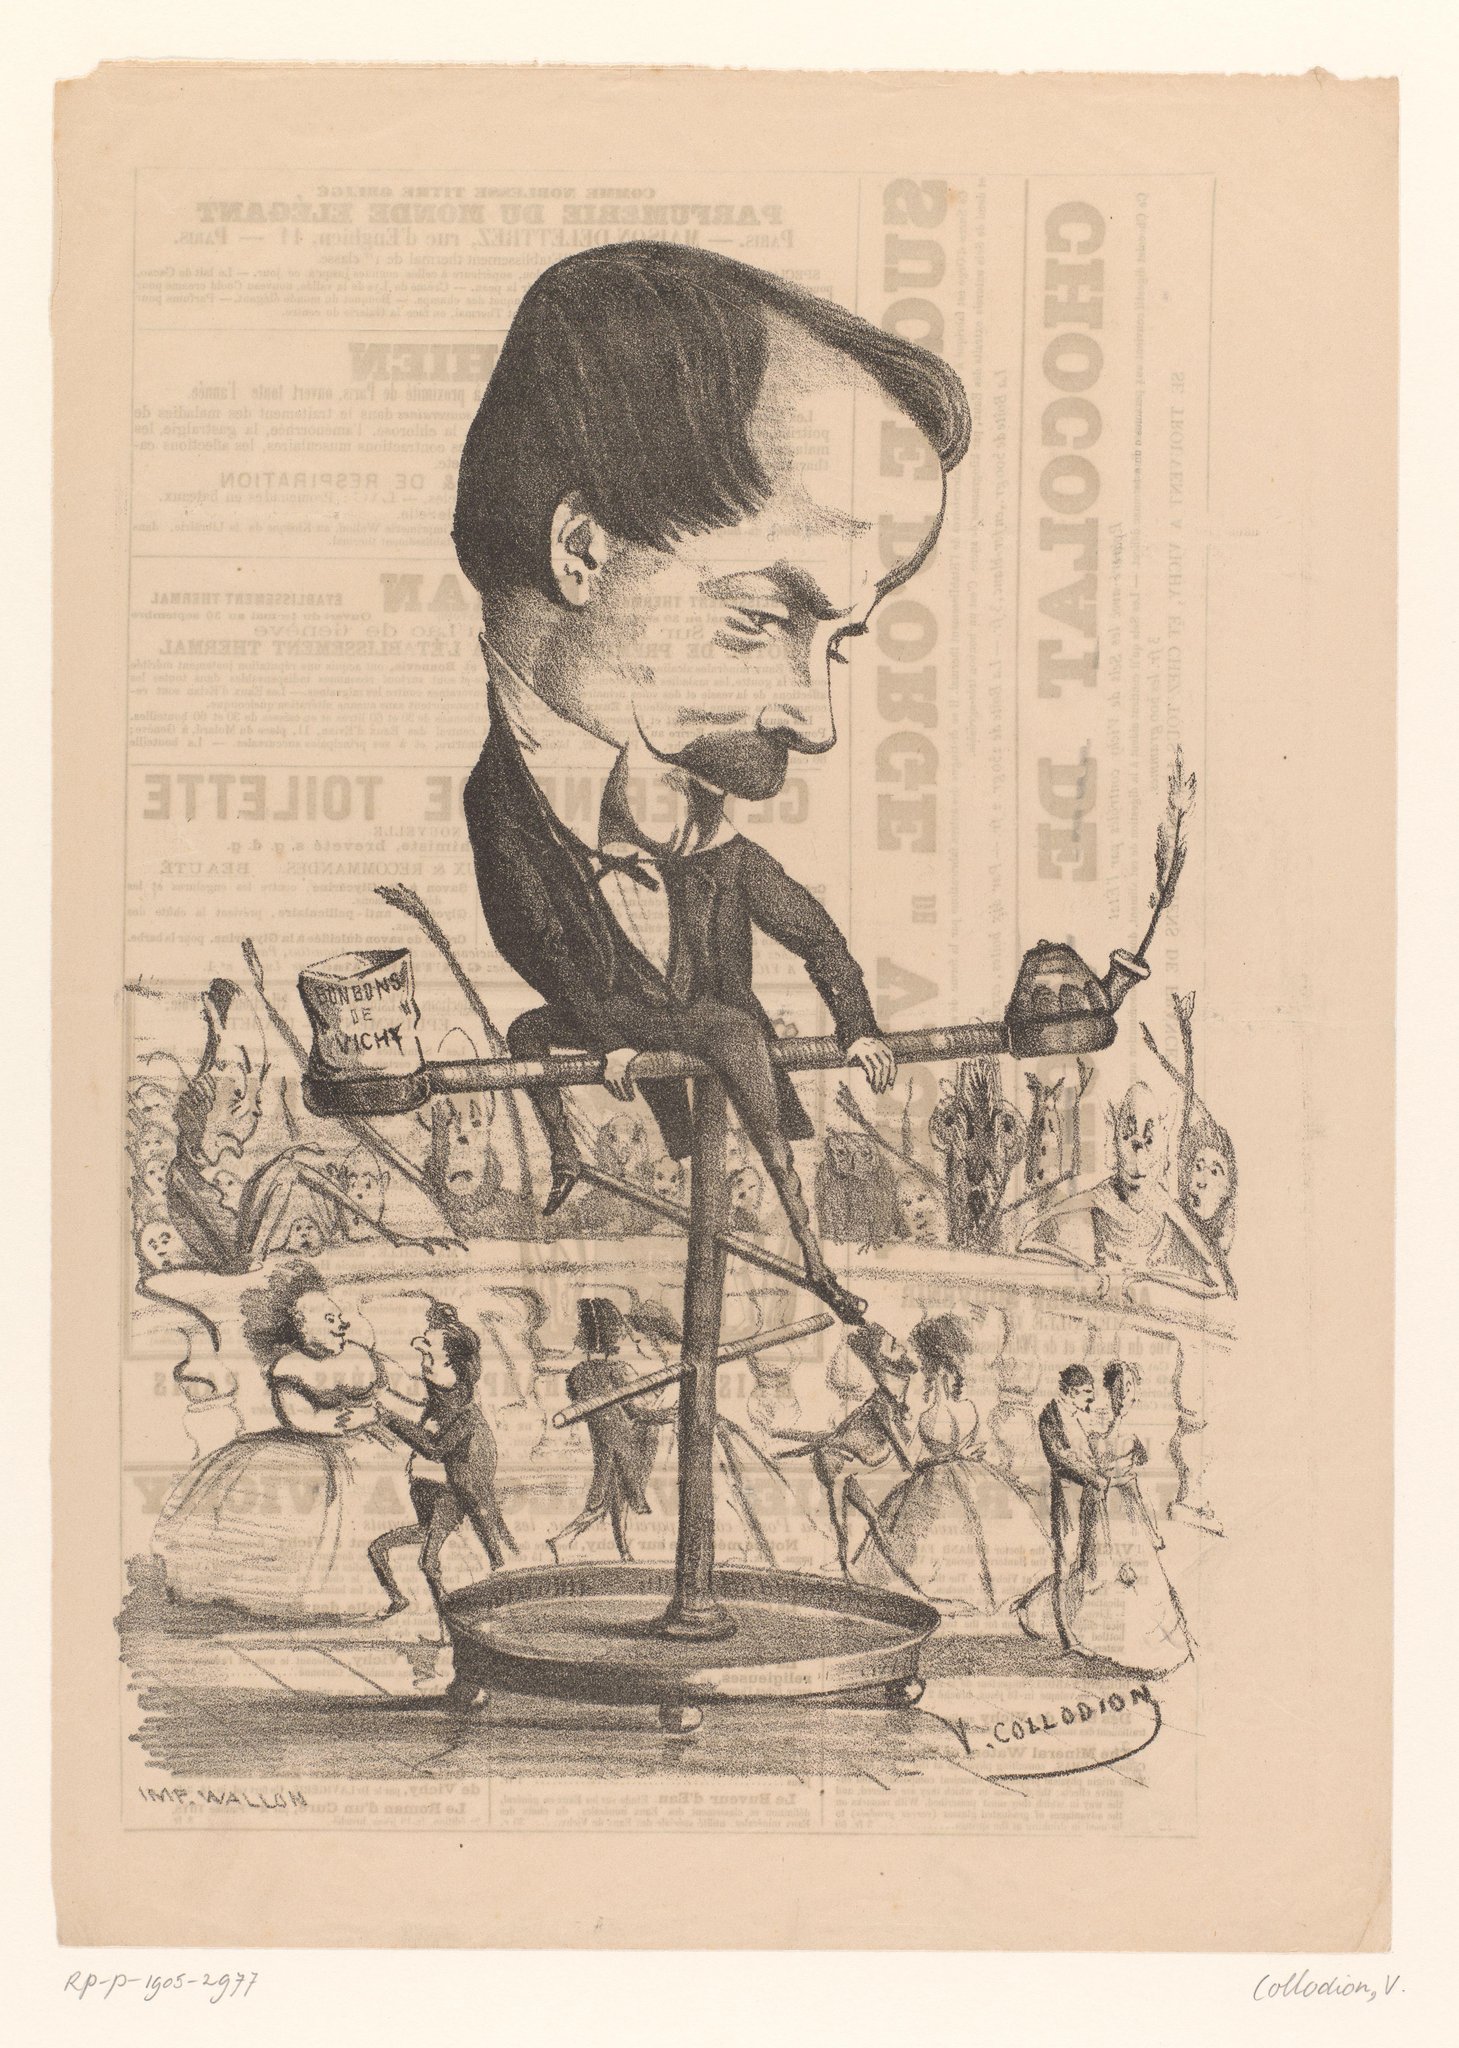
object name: cartoon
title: Karikatuur van een apotheker uit Vichy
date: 1866-1870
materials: paper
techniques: lithograph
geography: vichy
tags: pharmacist, druggist, apothecary; pharmacy, drugstore, dispensing chemist, balance, equilibrium (+ symbolical representation of concept), caricatures (human types), historical persons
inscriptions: collector's mark: Lugt 2228a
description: Prent gepubliceerd in: Le Programme de Vichy, 1866-1870. Tussen ca. 1859 en 1877 speelde in Vichy de juridische affaire tussen de apothekers Nicolas Larbaud en Monsieur Bru. Beiden beweerden de echte bonbons van Vichy te maken. In 1877 kreeg Larbaud uiteindelijk het monopolie op de verkoop van zout, pastilles en bonbons van Vichy. Zie Cassier, R., 'Nicolas Larbaud (1822-1889), pharmacien à Vichy', in: Revue d'Histoire de la Pharmacie (1998), pp. 429-430.